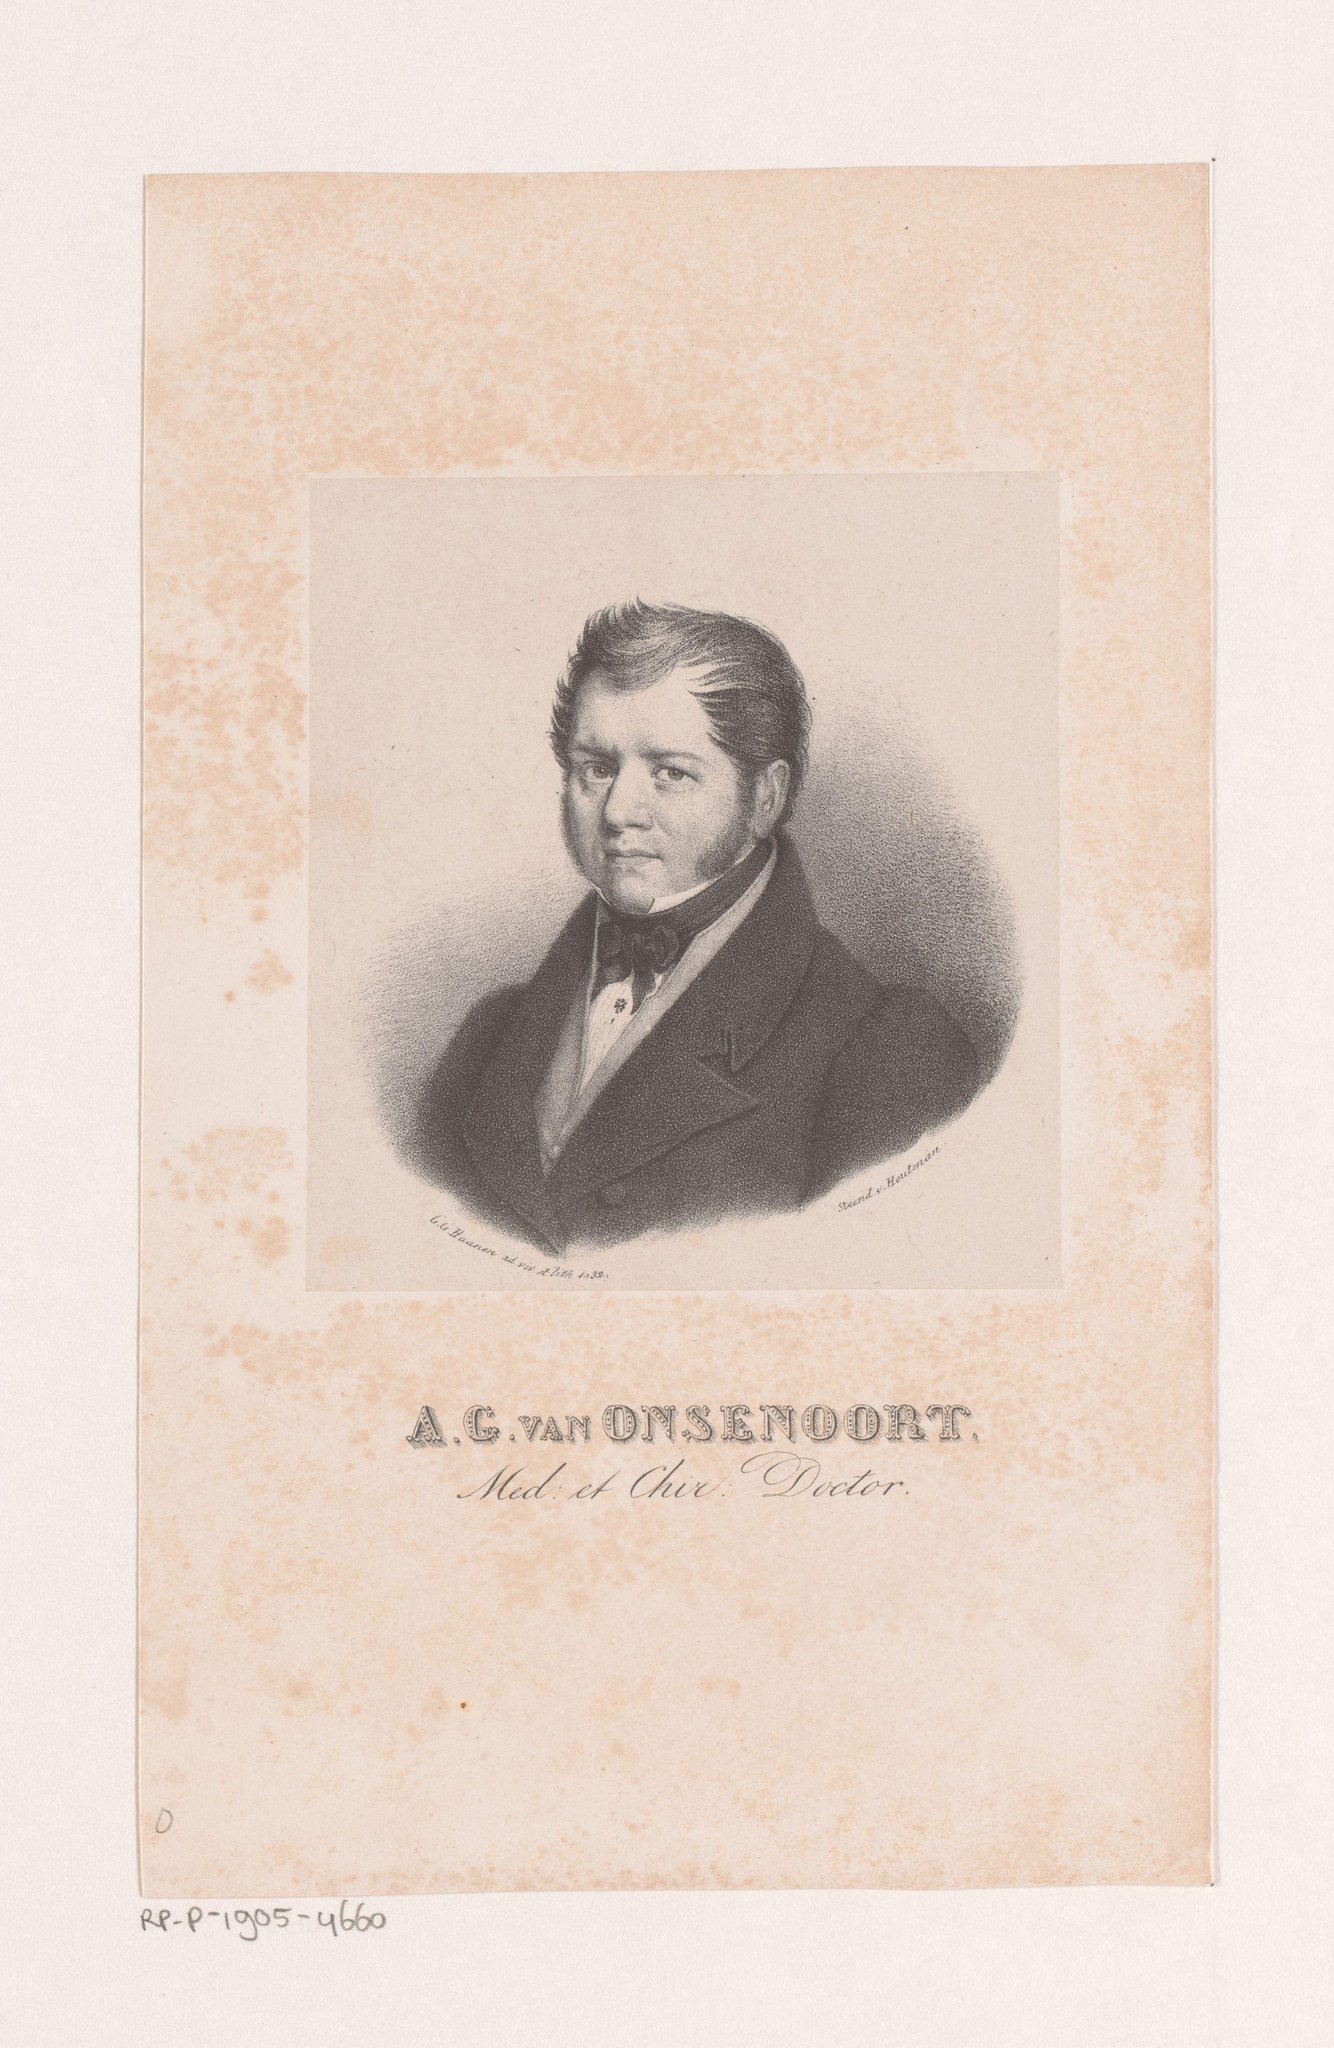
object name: print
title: Portret van Anthonius Gerardus van Onsenoort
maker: george gillis haanen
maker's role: draughtsman, painter, print maker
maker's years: 1807-1881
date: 1817-1881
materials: paper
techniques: lithograph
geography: netherlands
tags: historical persons (+ (full) bust portrait)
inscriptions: collector's mark: Lugt 2228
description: Ook gebruikt in A.G. van Onsenoot, De militaire chirurgie, geschiedkundig beschouwd en met betrekking tot derzelver uitoefening, zoo bij de land- en zeemagt, als in de koloniale dienst onderling vergeleken, […], Utrecht 1832